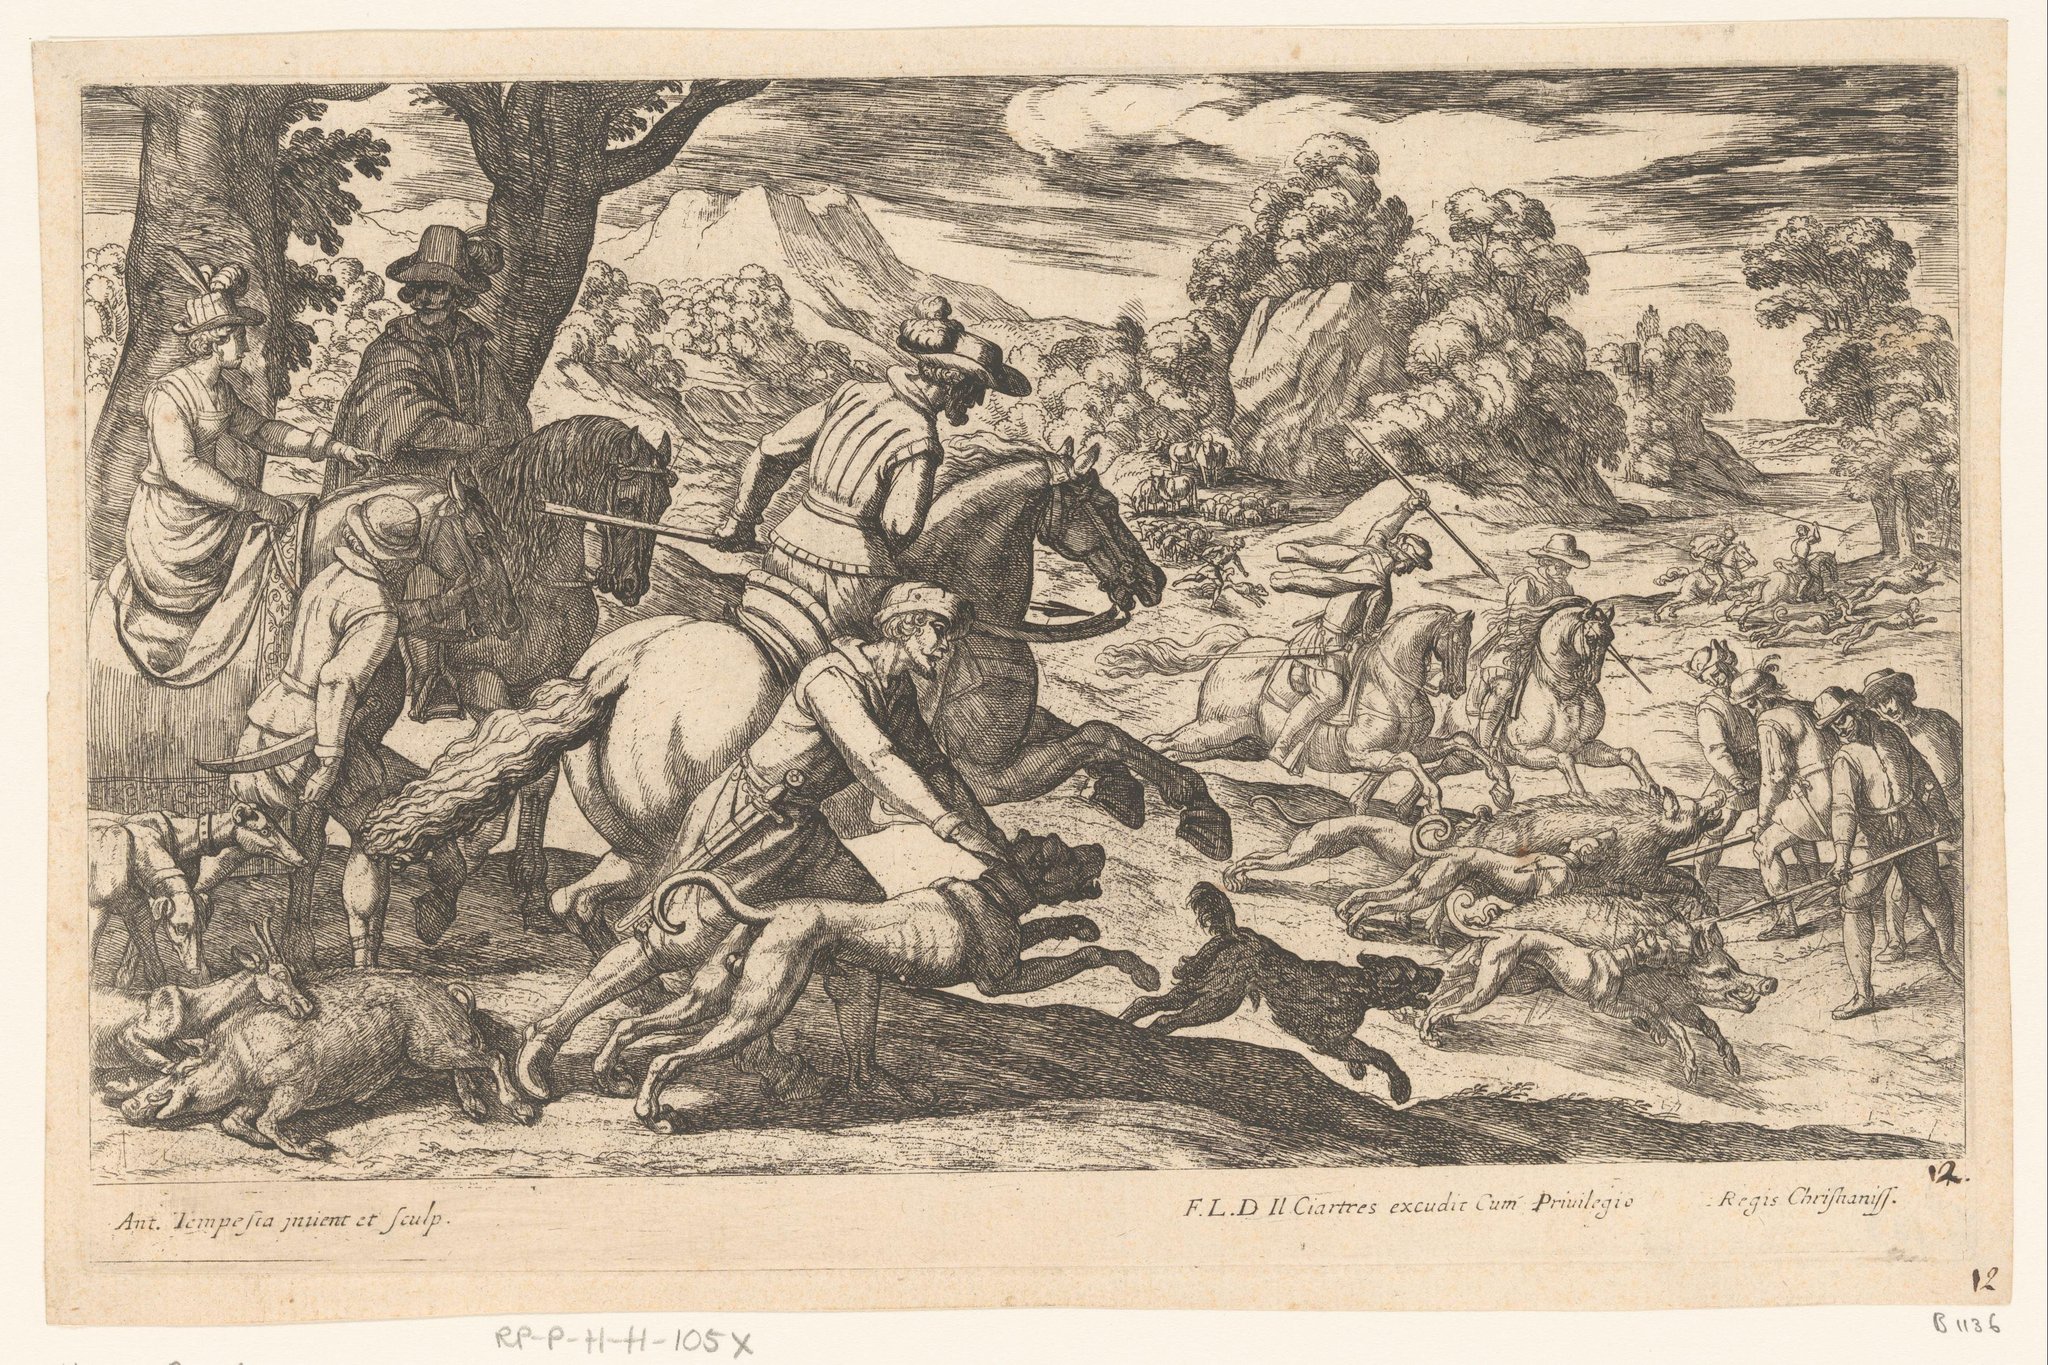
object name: print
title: Jachtscènes (deel 5)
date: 1600-1620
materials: paper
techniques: etching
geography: italy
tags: boar-hunting, hunter, hunters hunting (n.b.: in 1988-1990 this notation denoted the concept of 43c11421 'hunters resting during the hunt')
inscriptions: number: ‘12’, collector's mark: ‘Hinloopen’, collector's mark: Lugt 11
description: Deze prent maakt deel uit van een reeks van zeven prenten met jachtscènes.